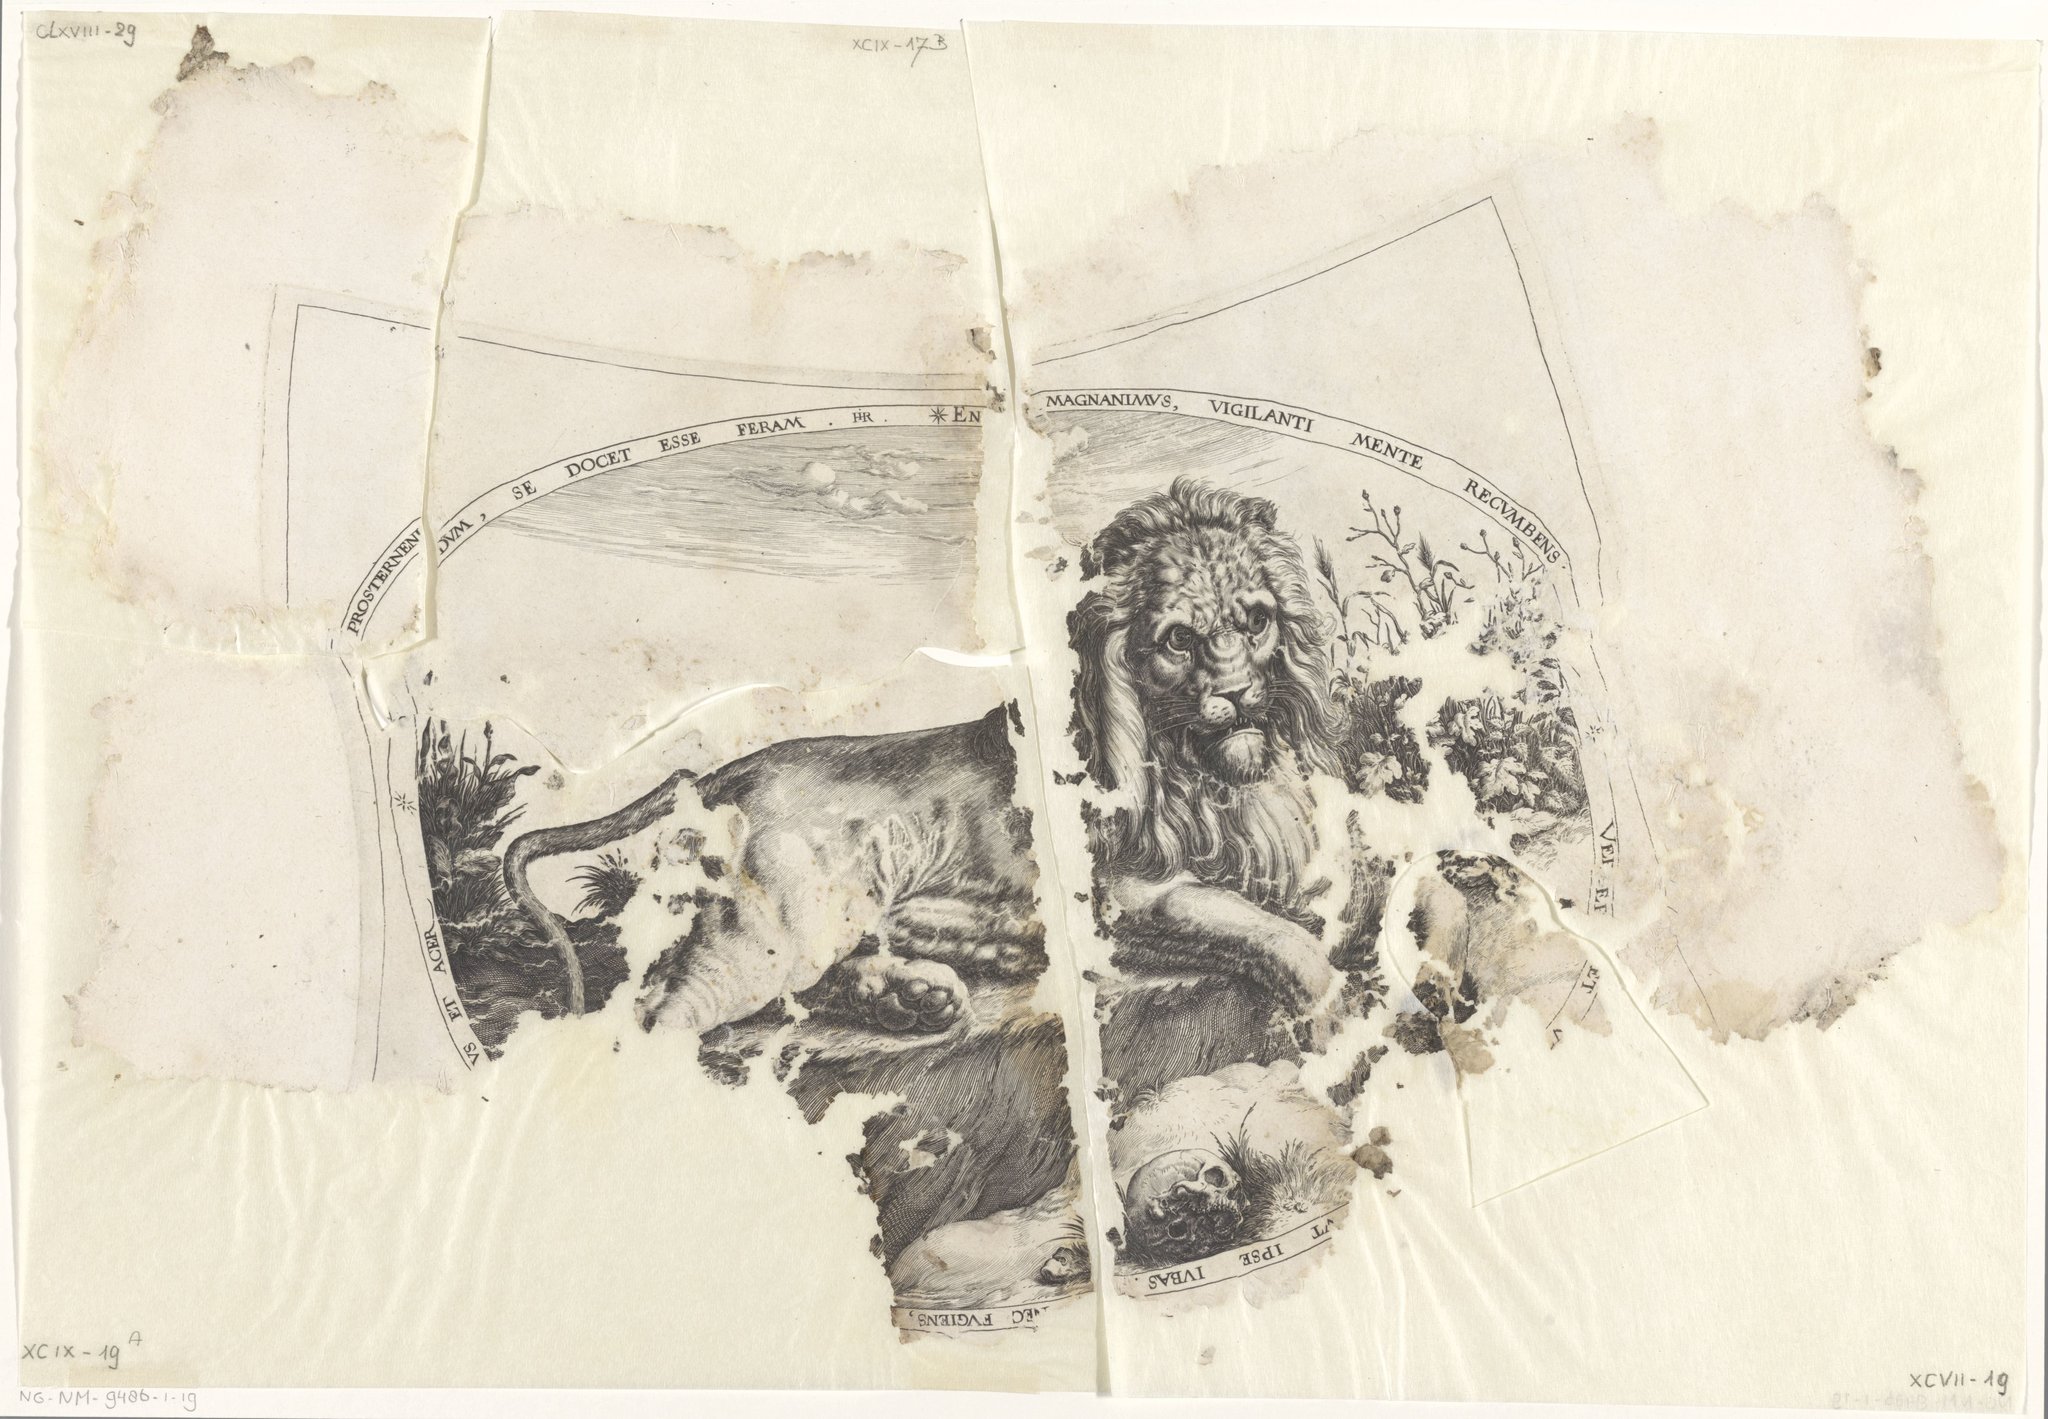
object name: print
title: Leeuw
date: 1580-1596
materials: paper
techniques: engraving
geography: northern netherlands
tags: beasts of prey, predatory animals: lion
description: De prenten in de Nova Zembla collectie zijn tijdens een expeditie van Willem Barendsz en Jacob van Heemskerk in 1596-1597 noodgedwongen in het winterkamp, het ‘Behouden Huis’, op het eiland achtergelaten. De prenten waren in één of meerdere stapels als handelswaar meegenomen vanuit Amsterdam. Bijna drie eeuwen later, in 1871, keerde de Noor Elling Carlsen terug naar Nova Zembla en vond daar de restanten van het ‘Behouden Huis, inclusief een groot deel van de inventaris. Een deel van de prenten, in de vorm van aaneengekoekte kluiten, werd toen ook teruggevonden. De papierkluiten waren soms op meerdere plekken gebroken. Tussen 1975-1979 zijn de prenten van elkaar gescheiden. Dit leverde in totaal ca. 1000 fragmenten van ca. 400 afdrukken van ca. 150 verschillende prenten op. Voor zover mogelijk zijn de fragmenten samengevoegd en zijn de prenten gereconstrueerd.